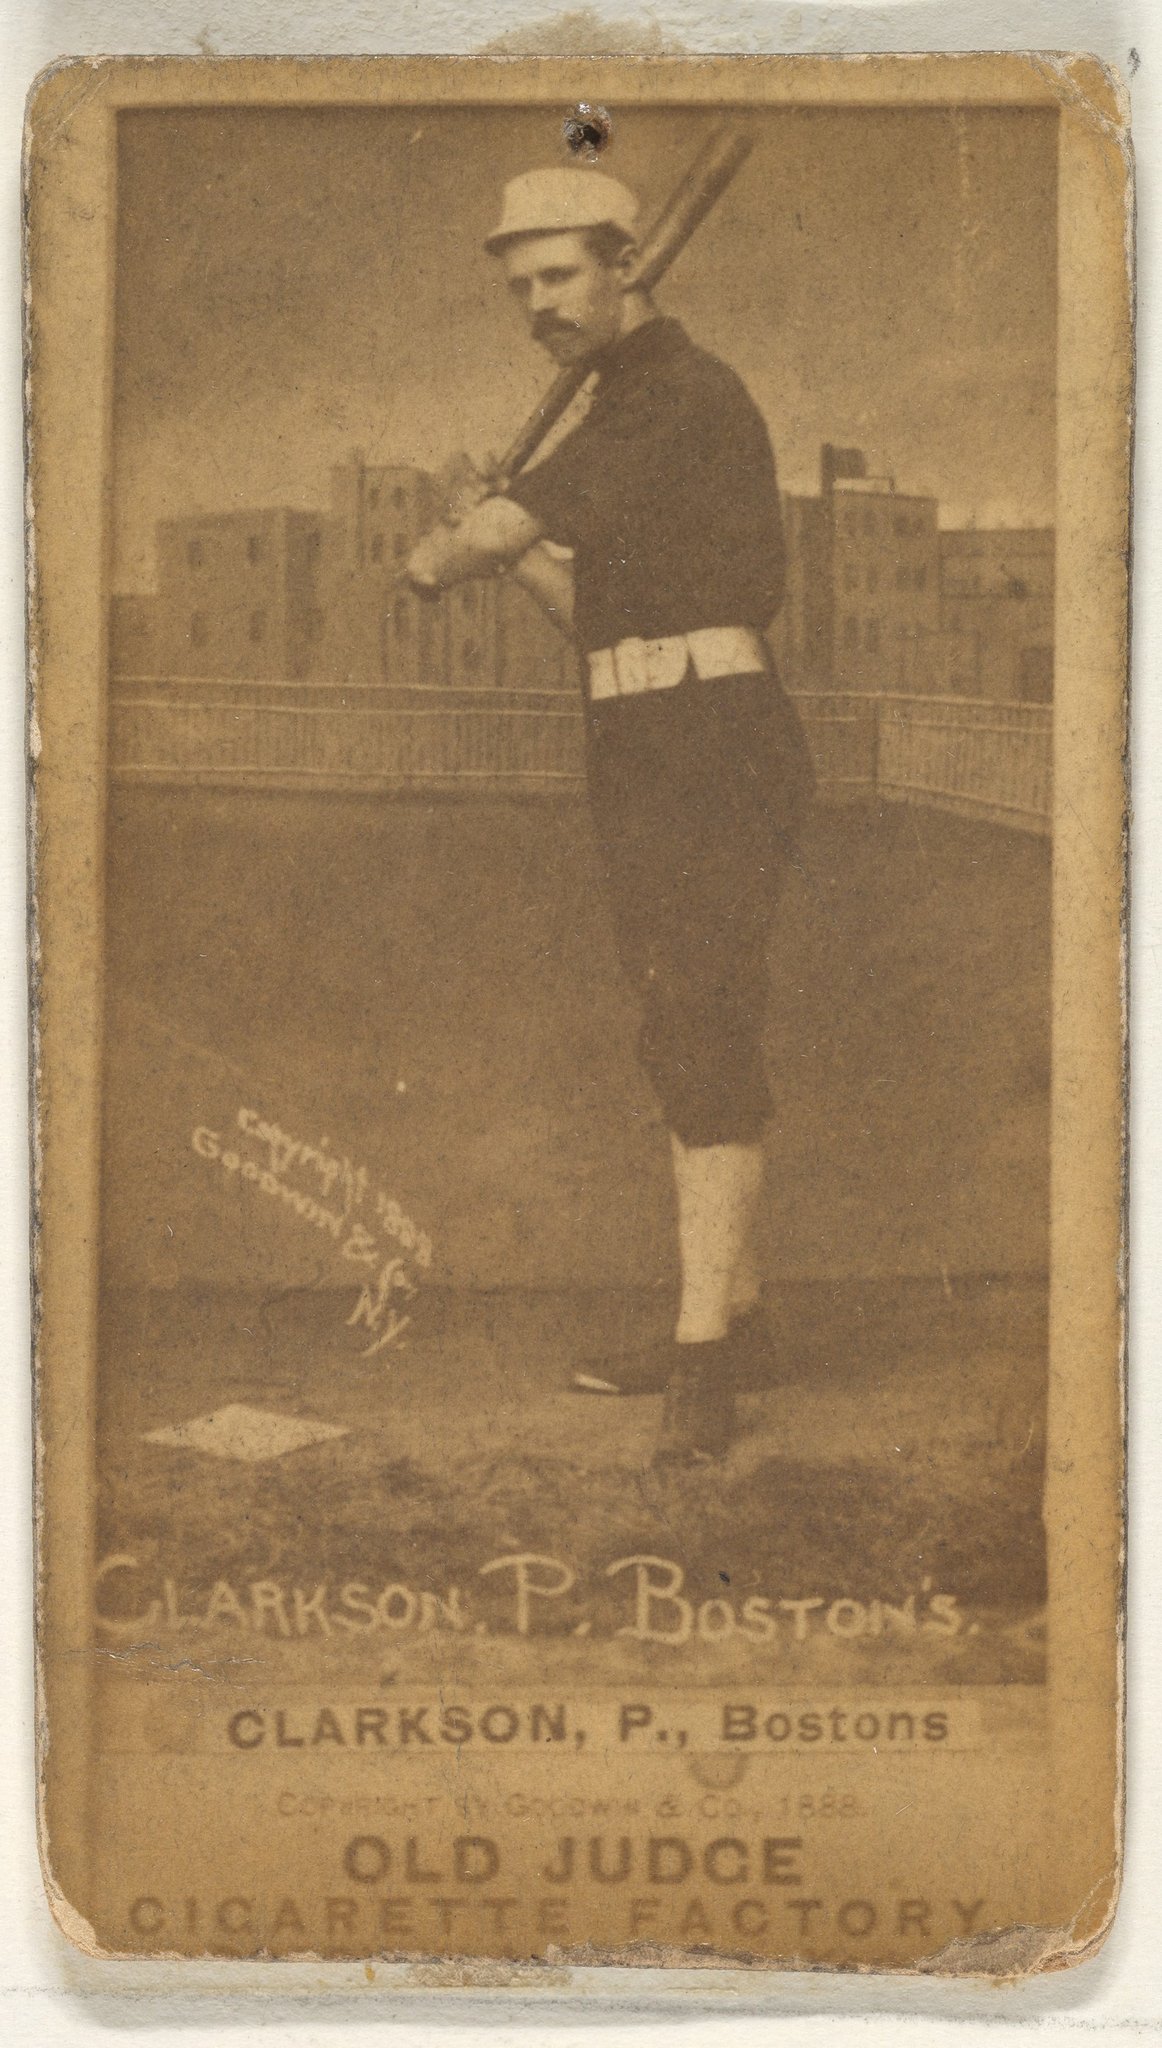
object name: baseball card, photograph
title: Clarkson, Pitcher, Boston, from the Old Judge series (N172) for Old Judge Cigarettes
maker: goodwin & company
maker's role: publisher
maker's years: 1850-1950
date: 1888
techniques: albumen silver print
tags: men,portraits,baseball,athletes